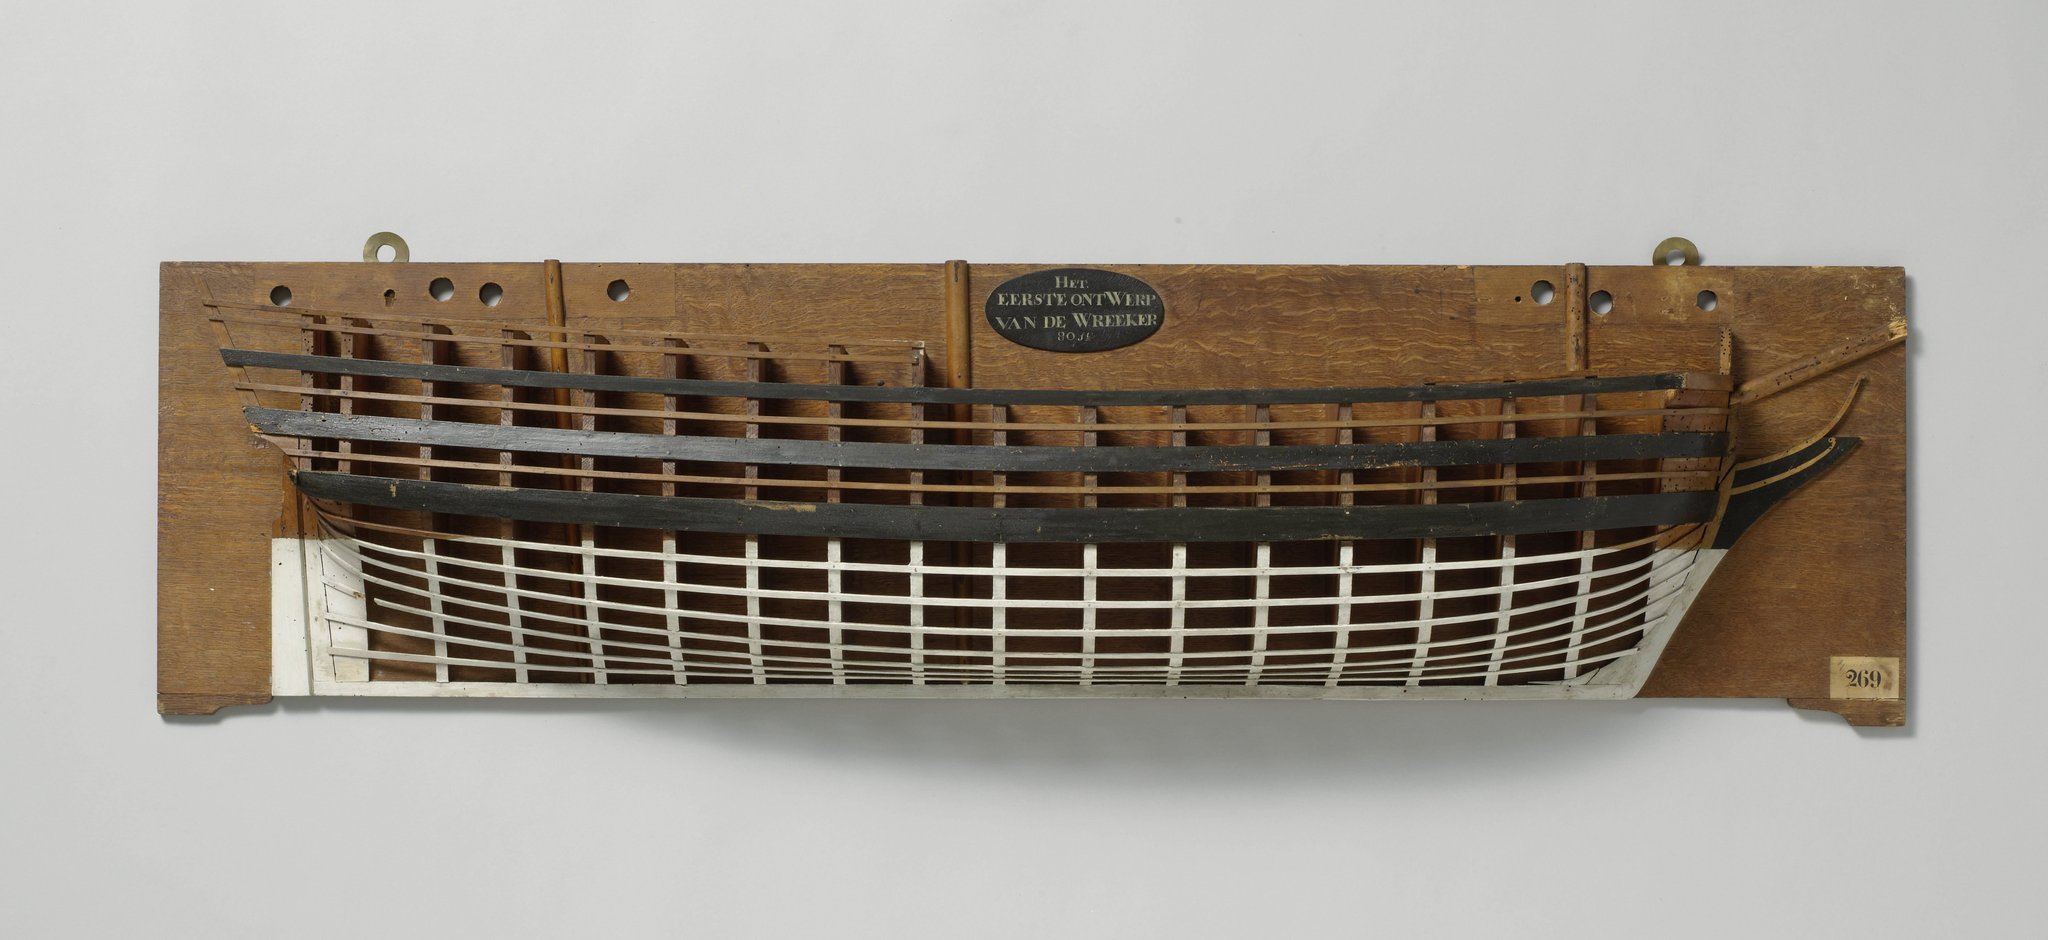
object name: builder's model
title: Half Model of an 80-Gun Ship of the Line 'Wreeker'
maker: Anonymous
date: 1797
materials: wood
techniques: polychromy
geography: netherlands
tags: koninklijke hollander (schip), wreeker (schip), prins (schip), prince (schip), kroonprins (schip)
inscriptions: inscription, top centre, on an oval black metal label: ‘HET. / EERSTE ONTWERP / VAN DE WREEKER / 80 st.’, label, bottom right: ‘269’ former inventory label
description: Dit model stelt het eerste ontwerp van het linieschip van 80 stukken de Wreeker voor, lang 195 voet, in 1797-1798 door R. Dorsman in Rotterdam gebouwd, in 1806 herdoopt Koninklijke Hollander, in 1808 de Kroonprins, in 1810 Prince en in 1814 de Prins; gesloopt in 1819.